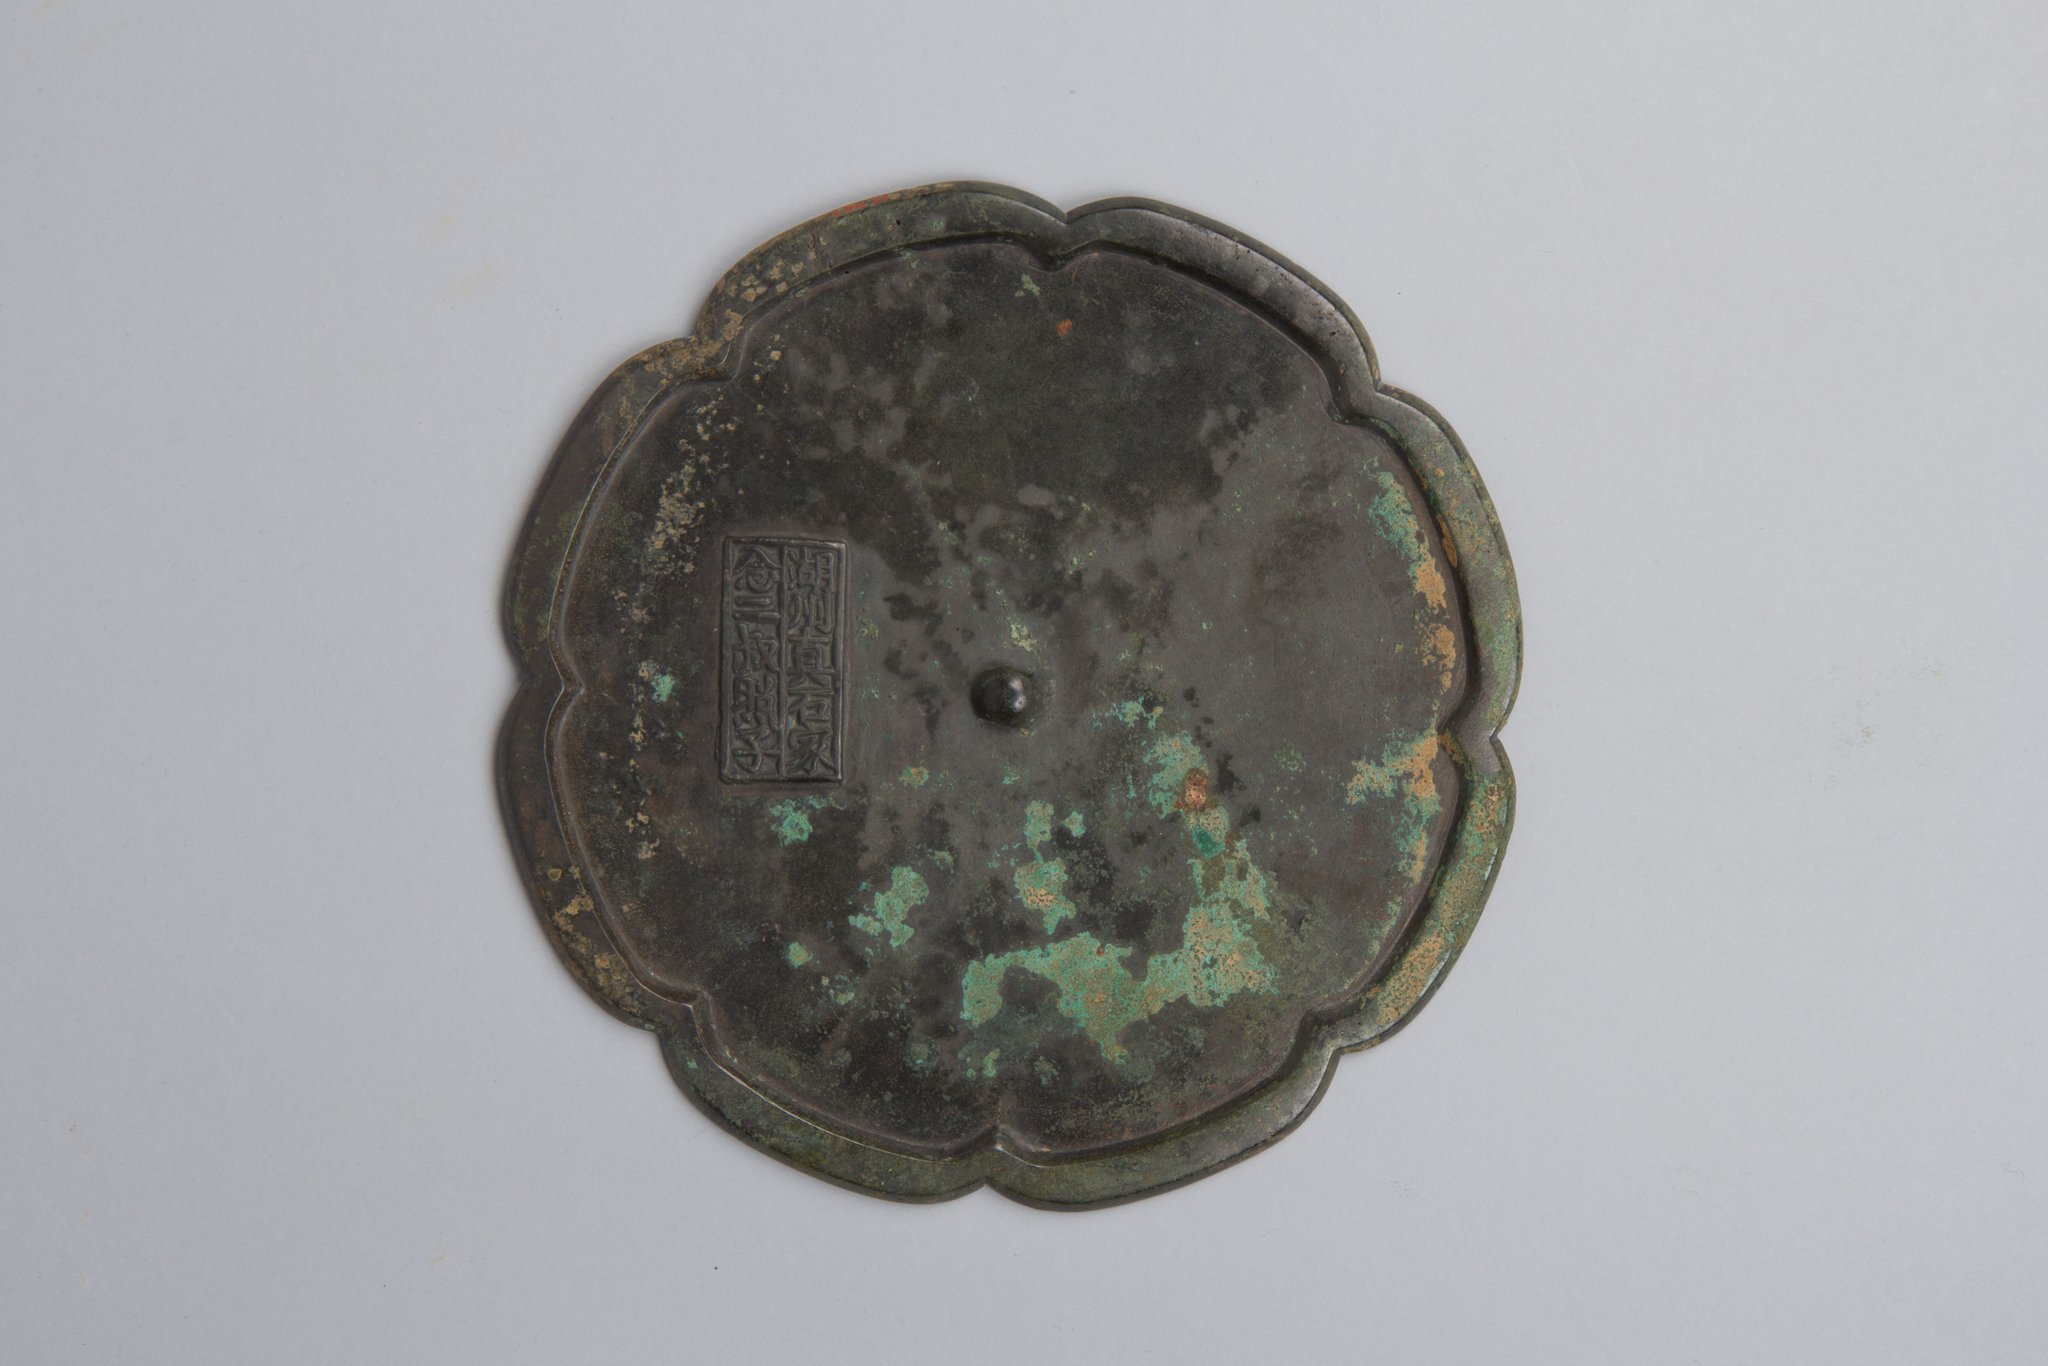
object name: mirror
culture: chinese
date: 1101-1200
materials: copper alloy